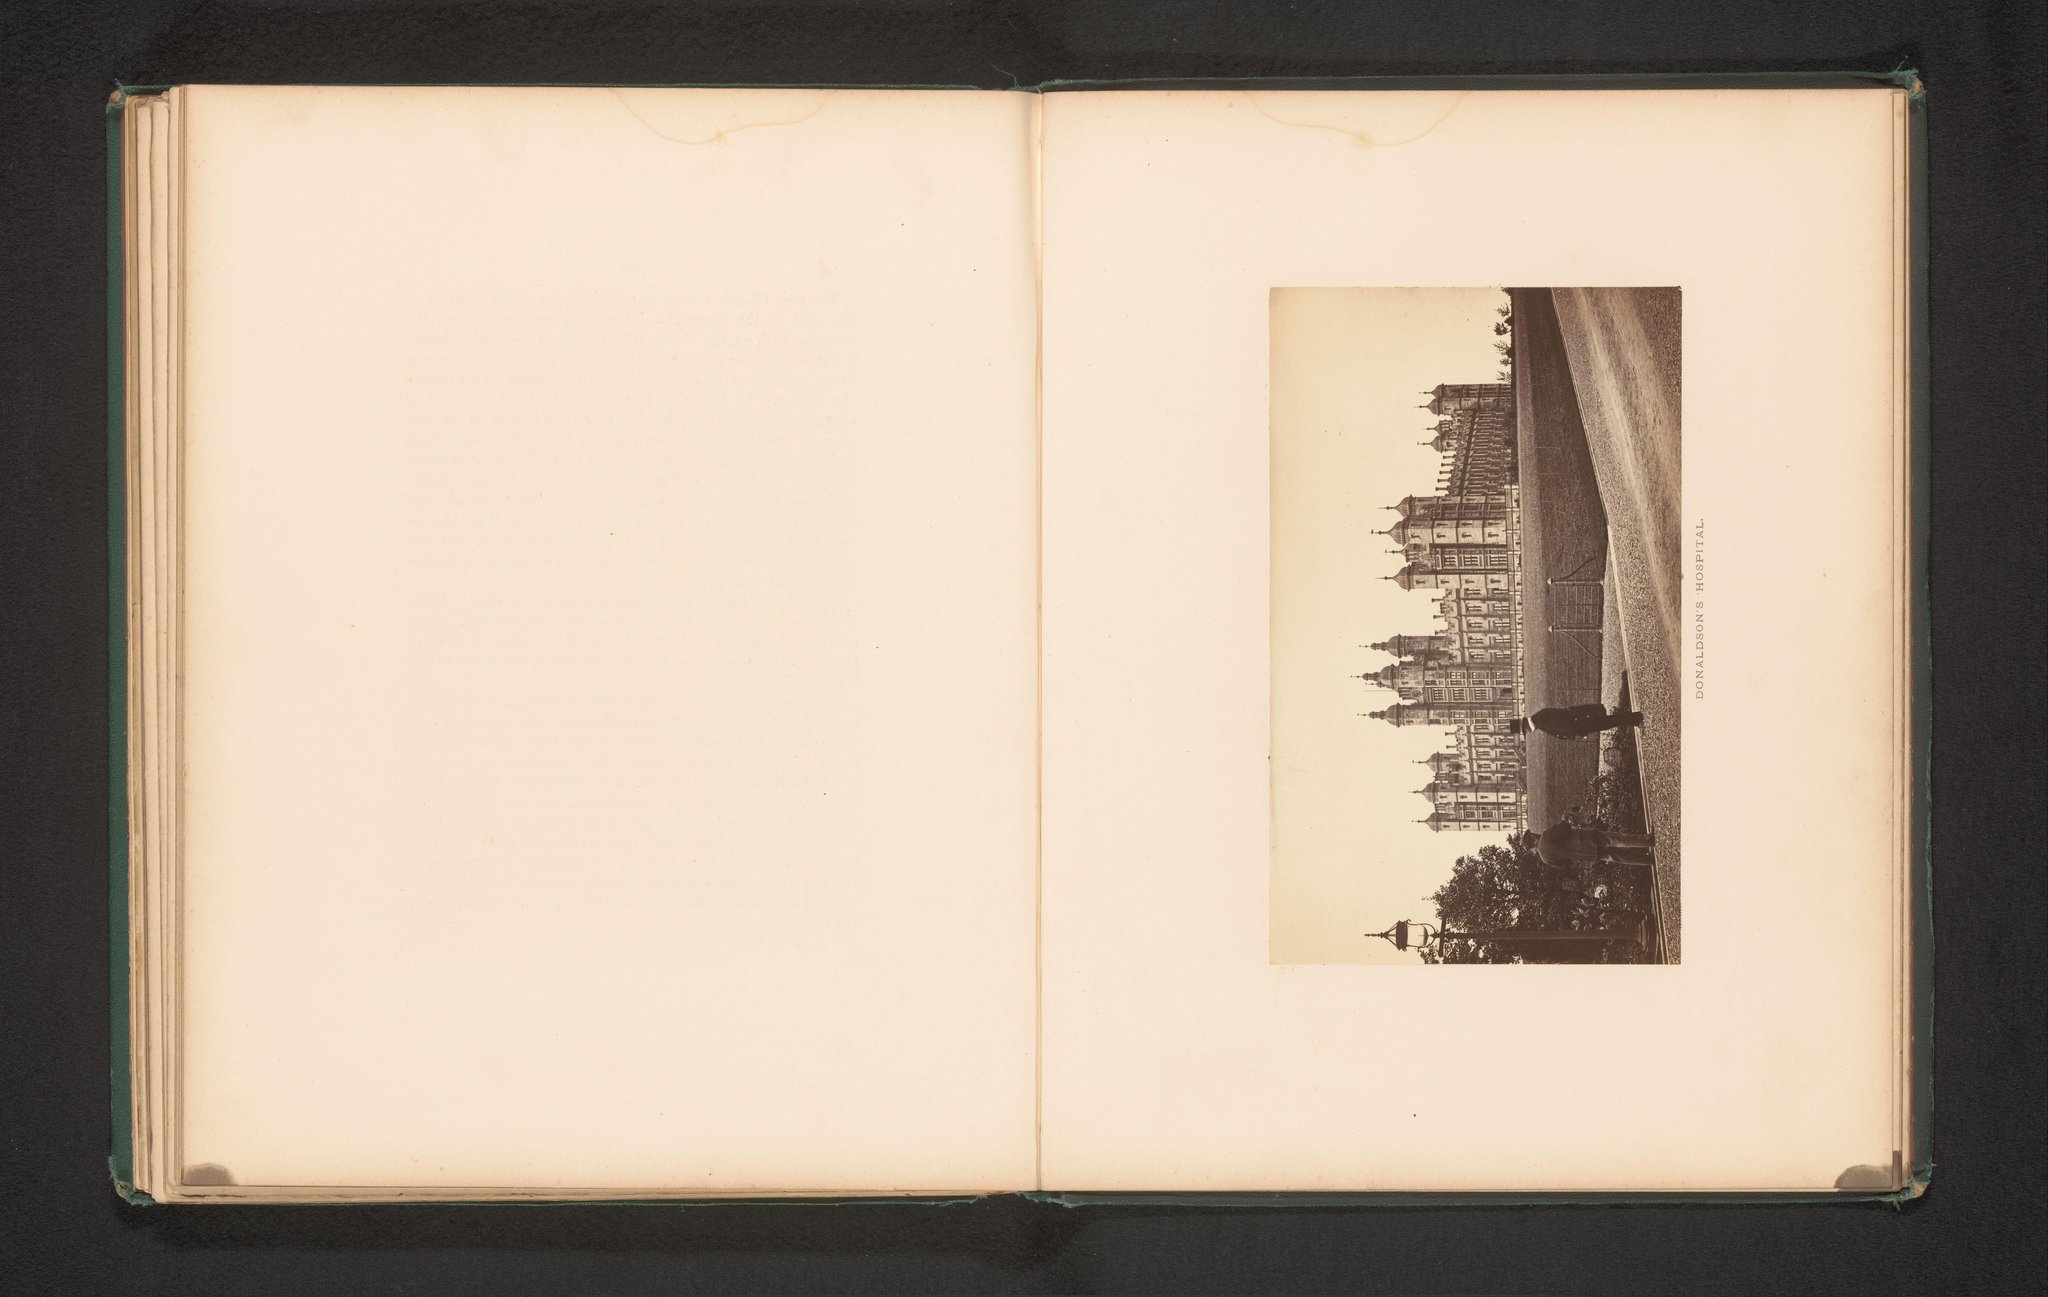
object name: page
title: Donaldson's Hospital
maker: archibald burns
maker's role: fotograaf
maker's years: 1831-1880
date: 1862-1867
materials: photographic support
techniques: albumen print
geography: edinburgh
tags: city-view in general; 'veduta', civic architecture; edifices; dwellings